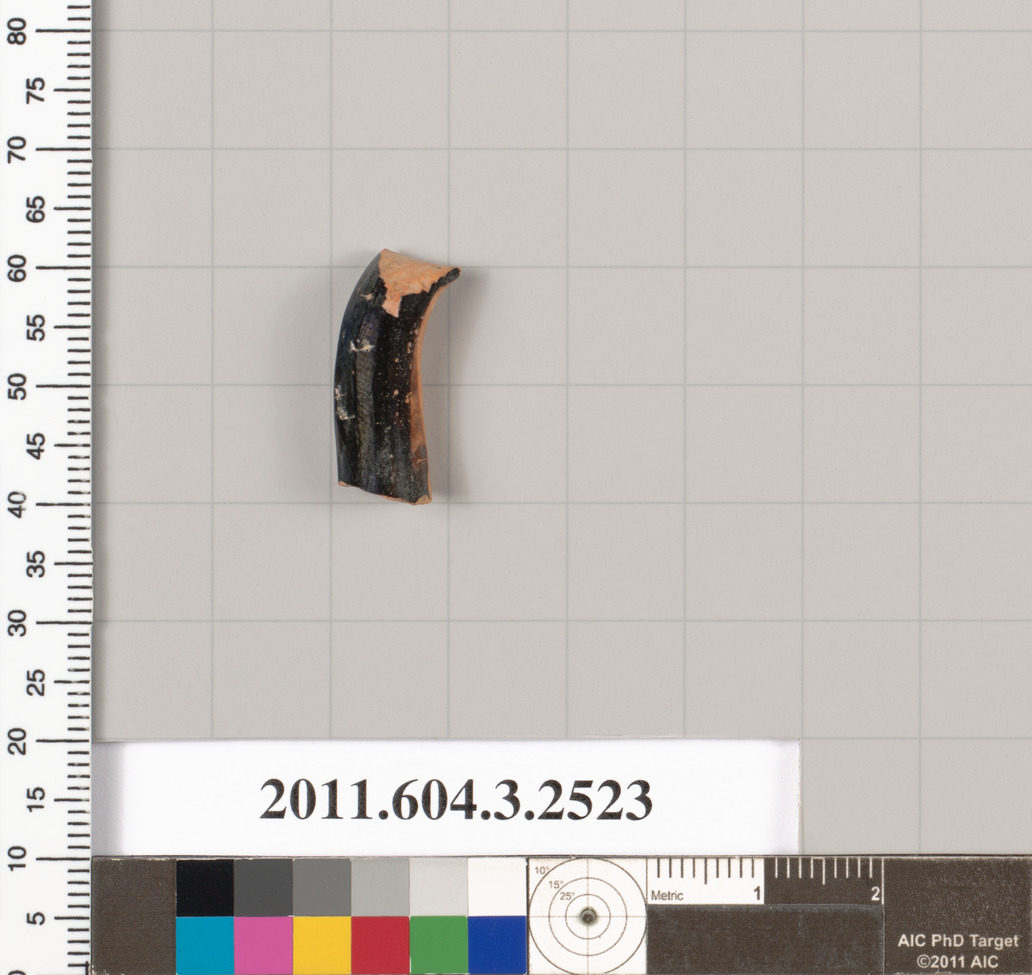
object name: kylix fragment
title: Terracotta fragment of a kylix (drinking cup)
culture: greek, attic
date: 600-401 BCE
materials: terracotta